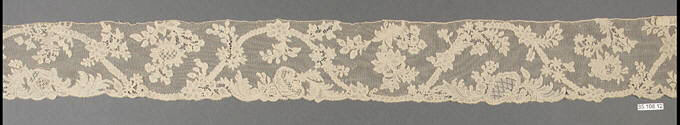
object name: edging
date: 1701-1800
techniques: lace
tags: flowers